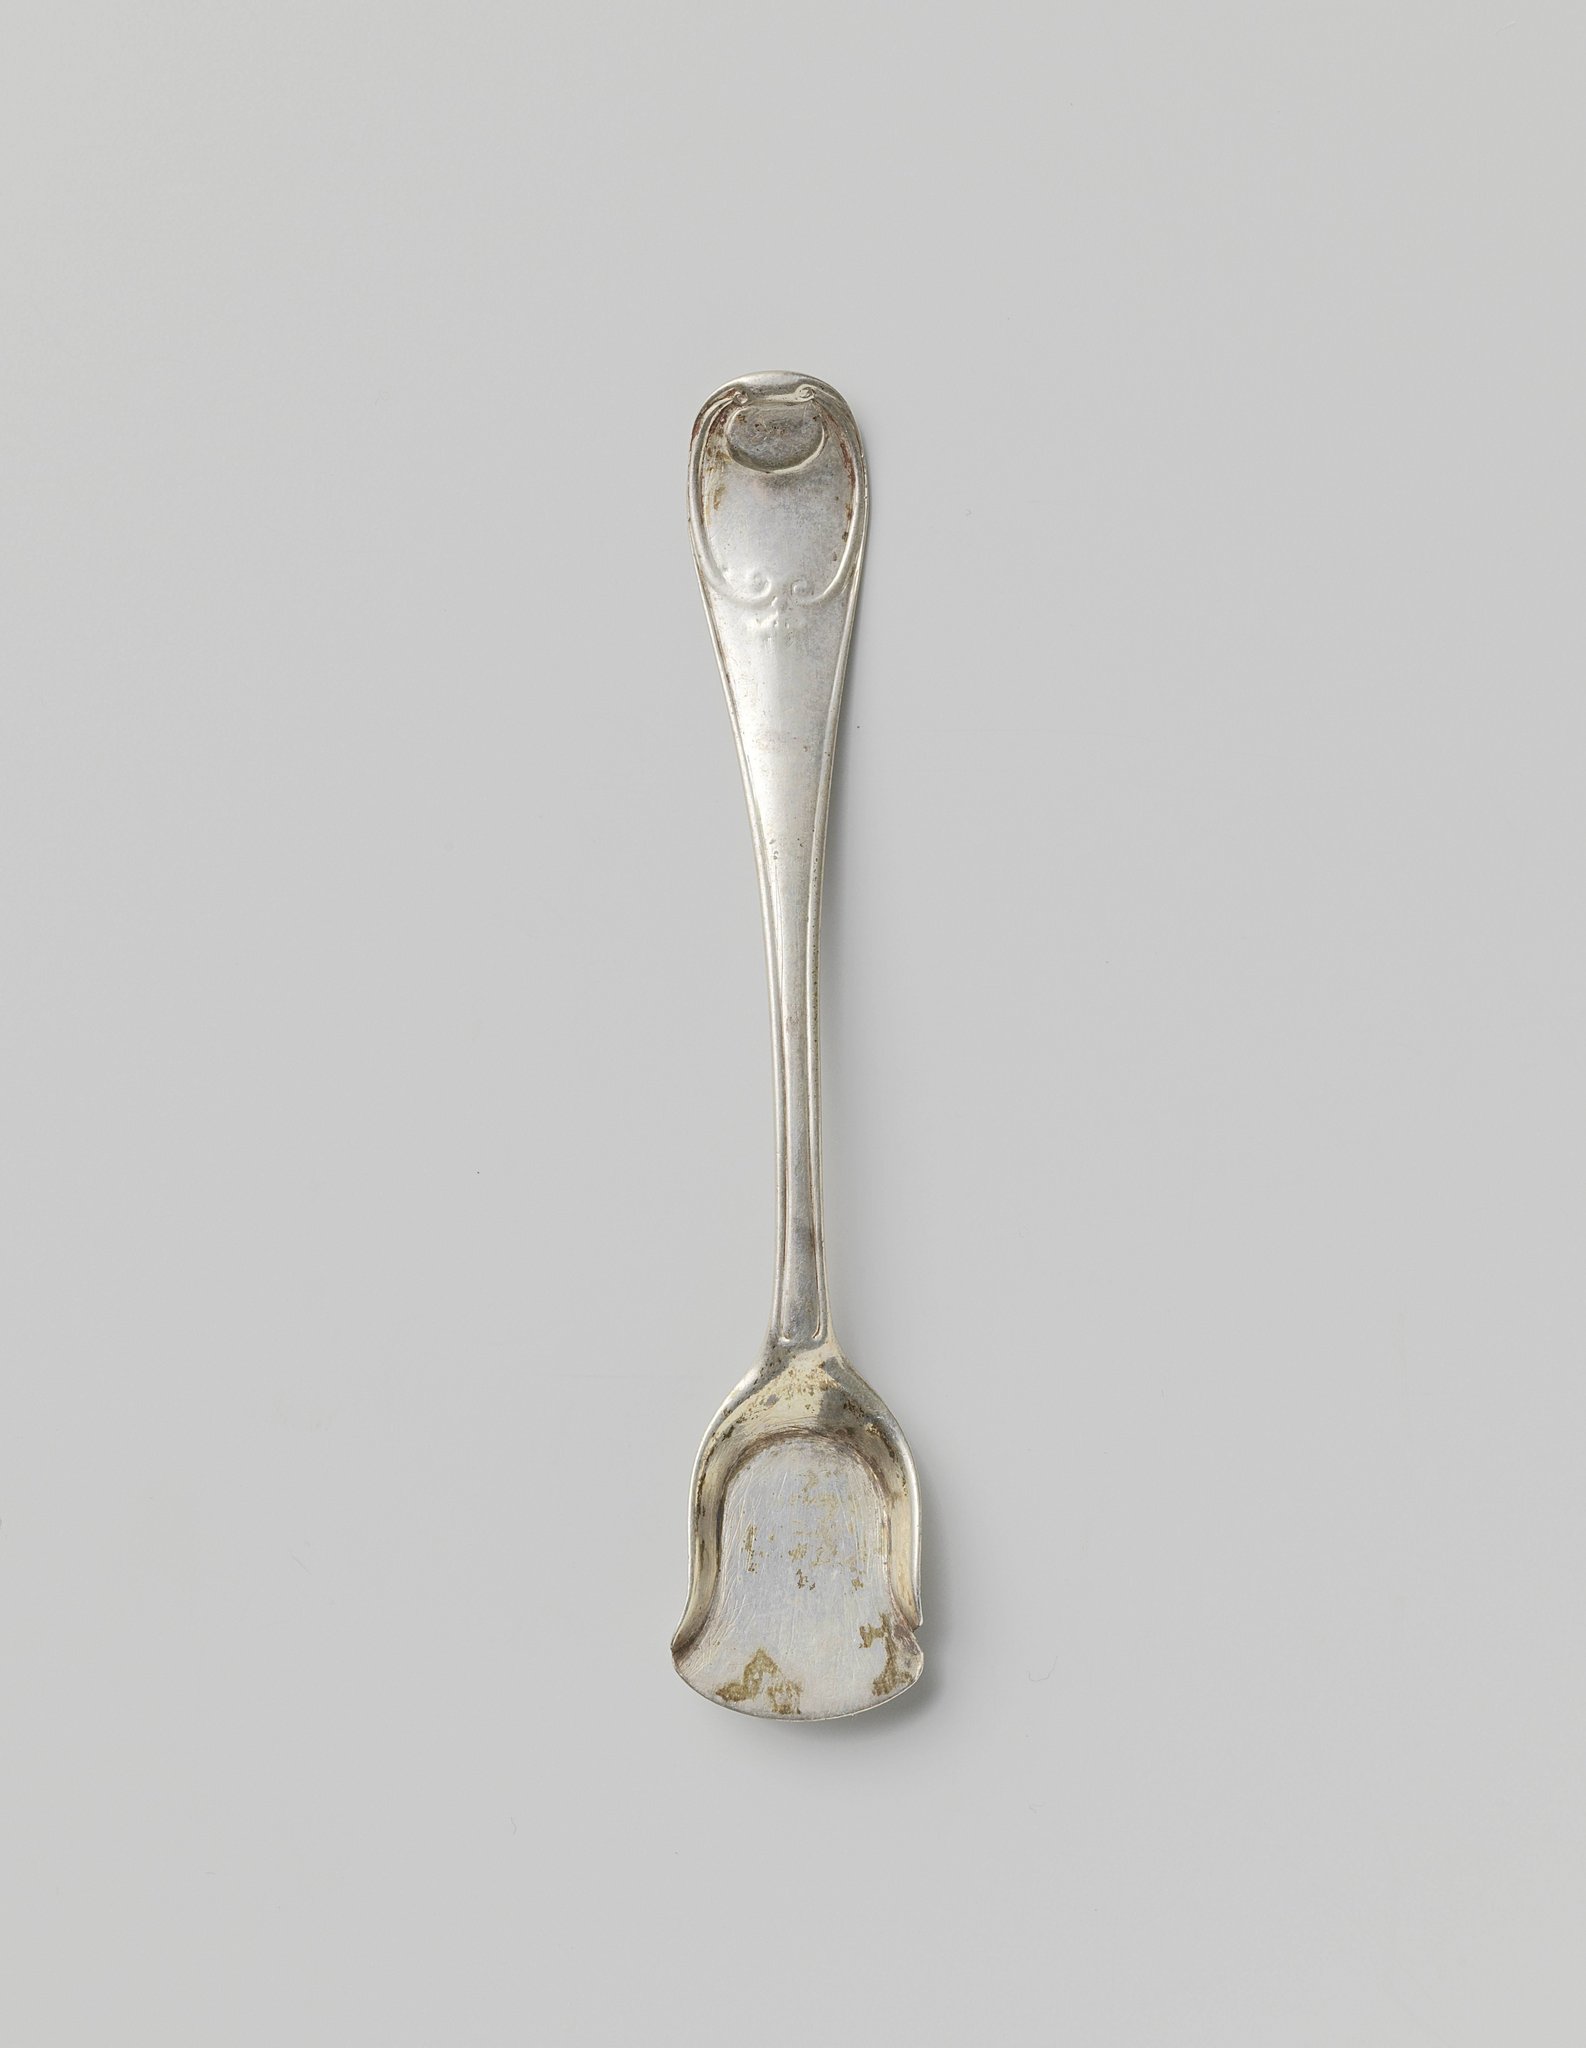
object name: salt spoon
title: Zoutlepel van zilver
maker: jacob schenk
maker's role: silversmith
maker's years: 1722-1786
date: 1790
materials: silver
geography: amsterdam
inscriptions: mark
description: Zoutlepel van zilver, met schepvormige bak. De onderzijde van het uiteinde van de steel is gegraveerd.